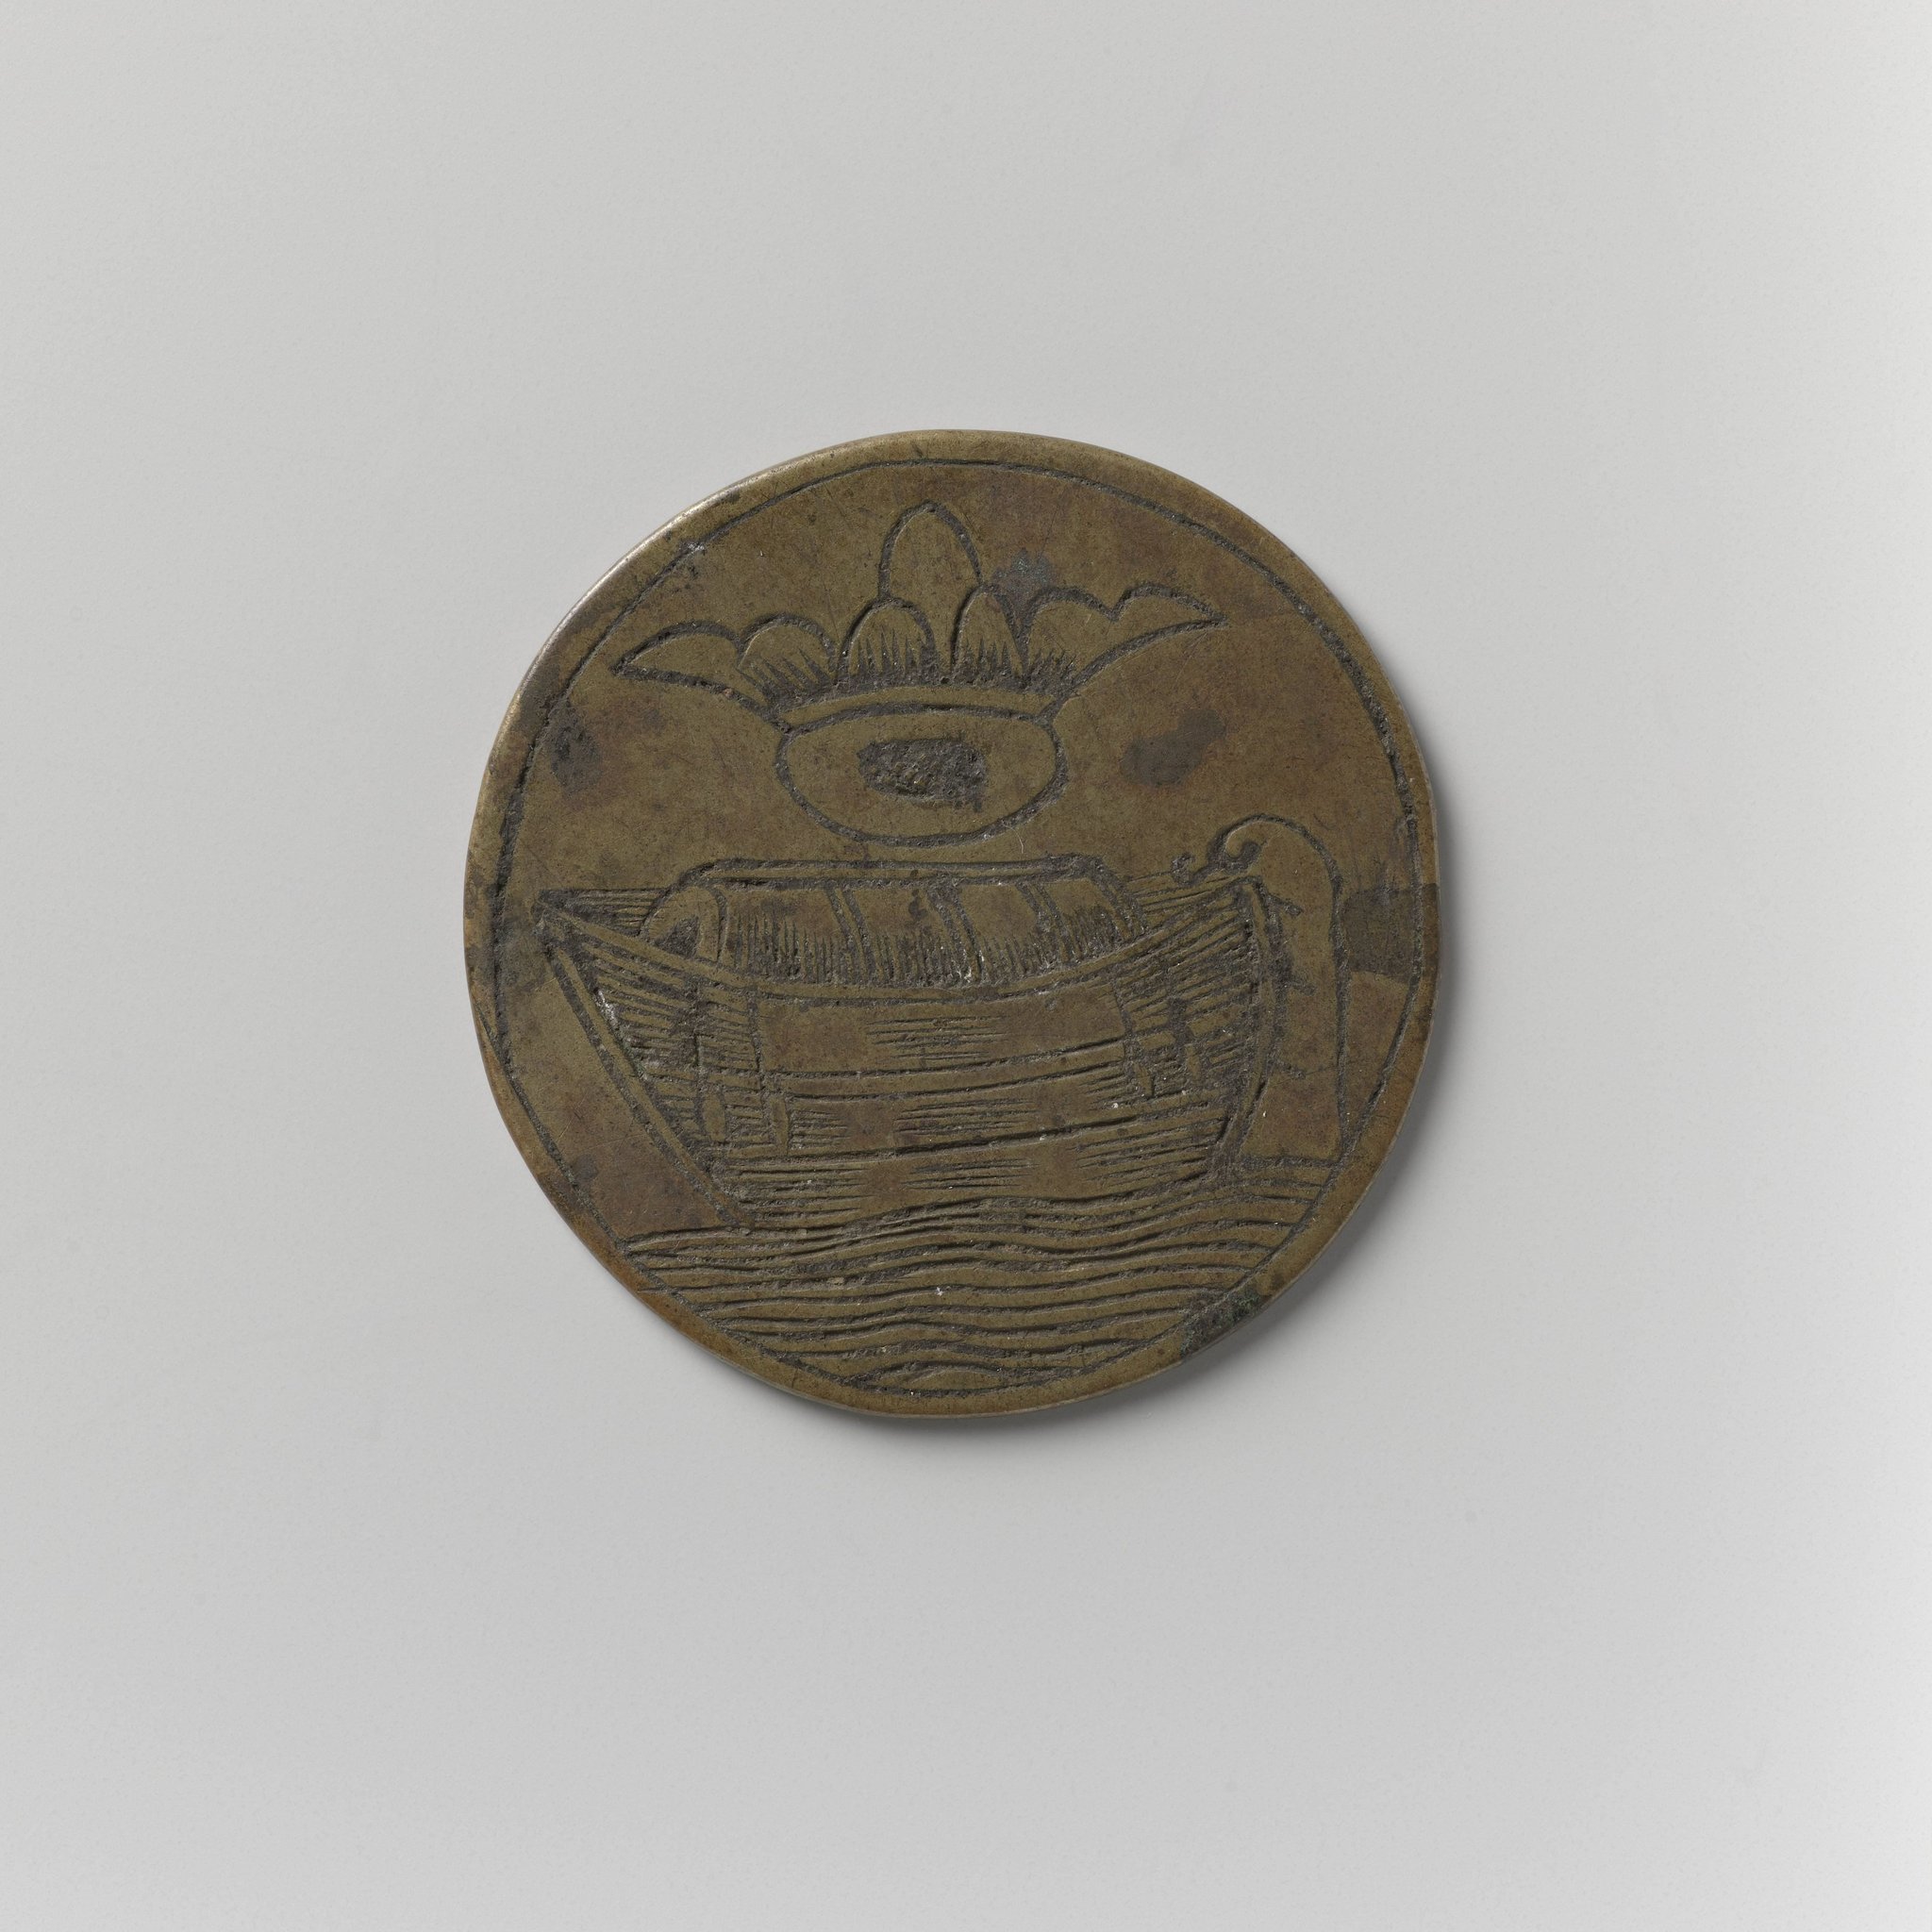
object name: medal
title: Korenlichtermansgilde van Amsterdam, gildepenning van Matheus Kruyck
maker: Anonymous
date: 1709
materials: brass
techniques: engraving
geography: amsterdam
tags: amsterdam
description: Messing penning. Voorzijde: korenlichter onder kroon. Keerzijde: opschrift